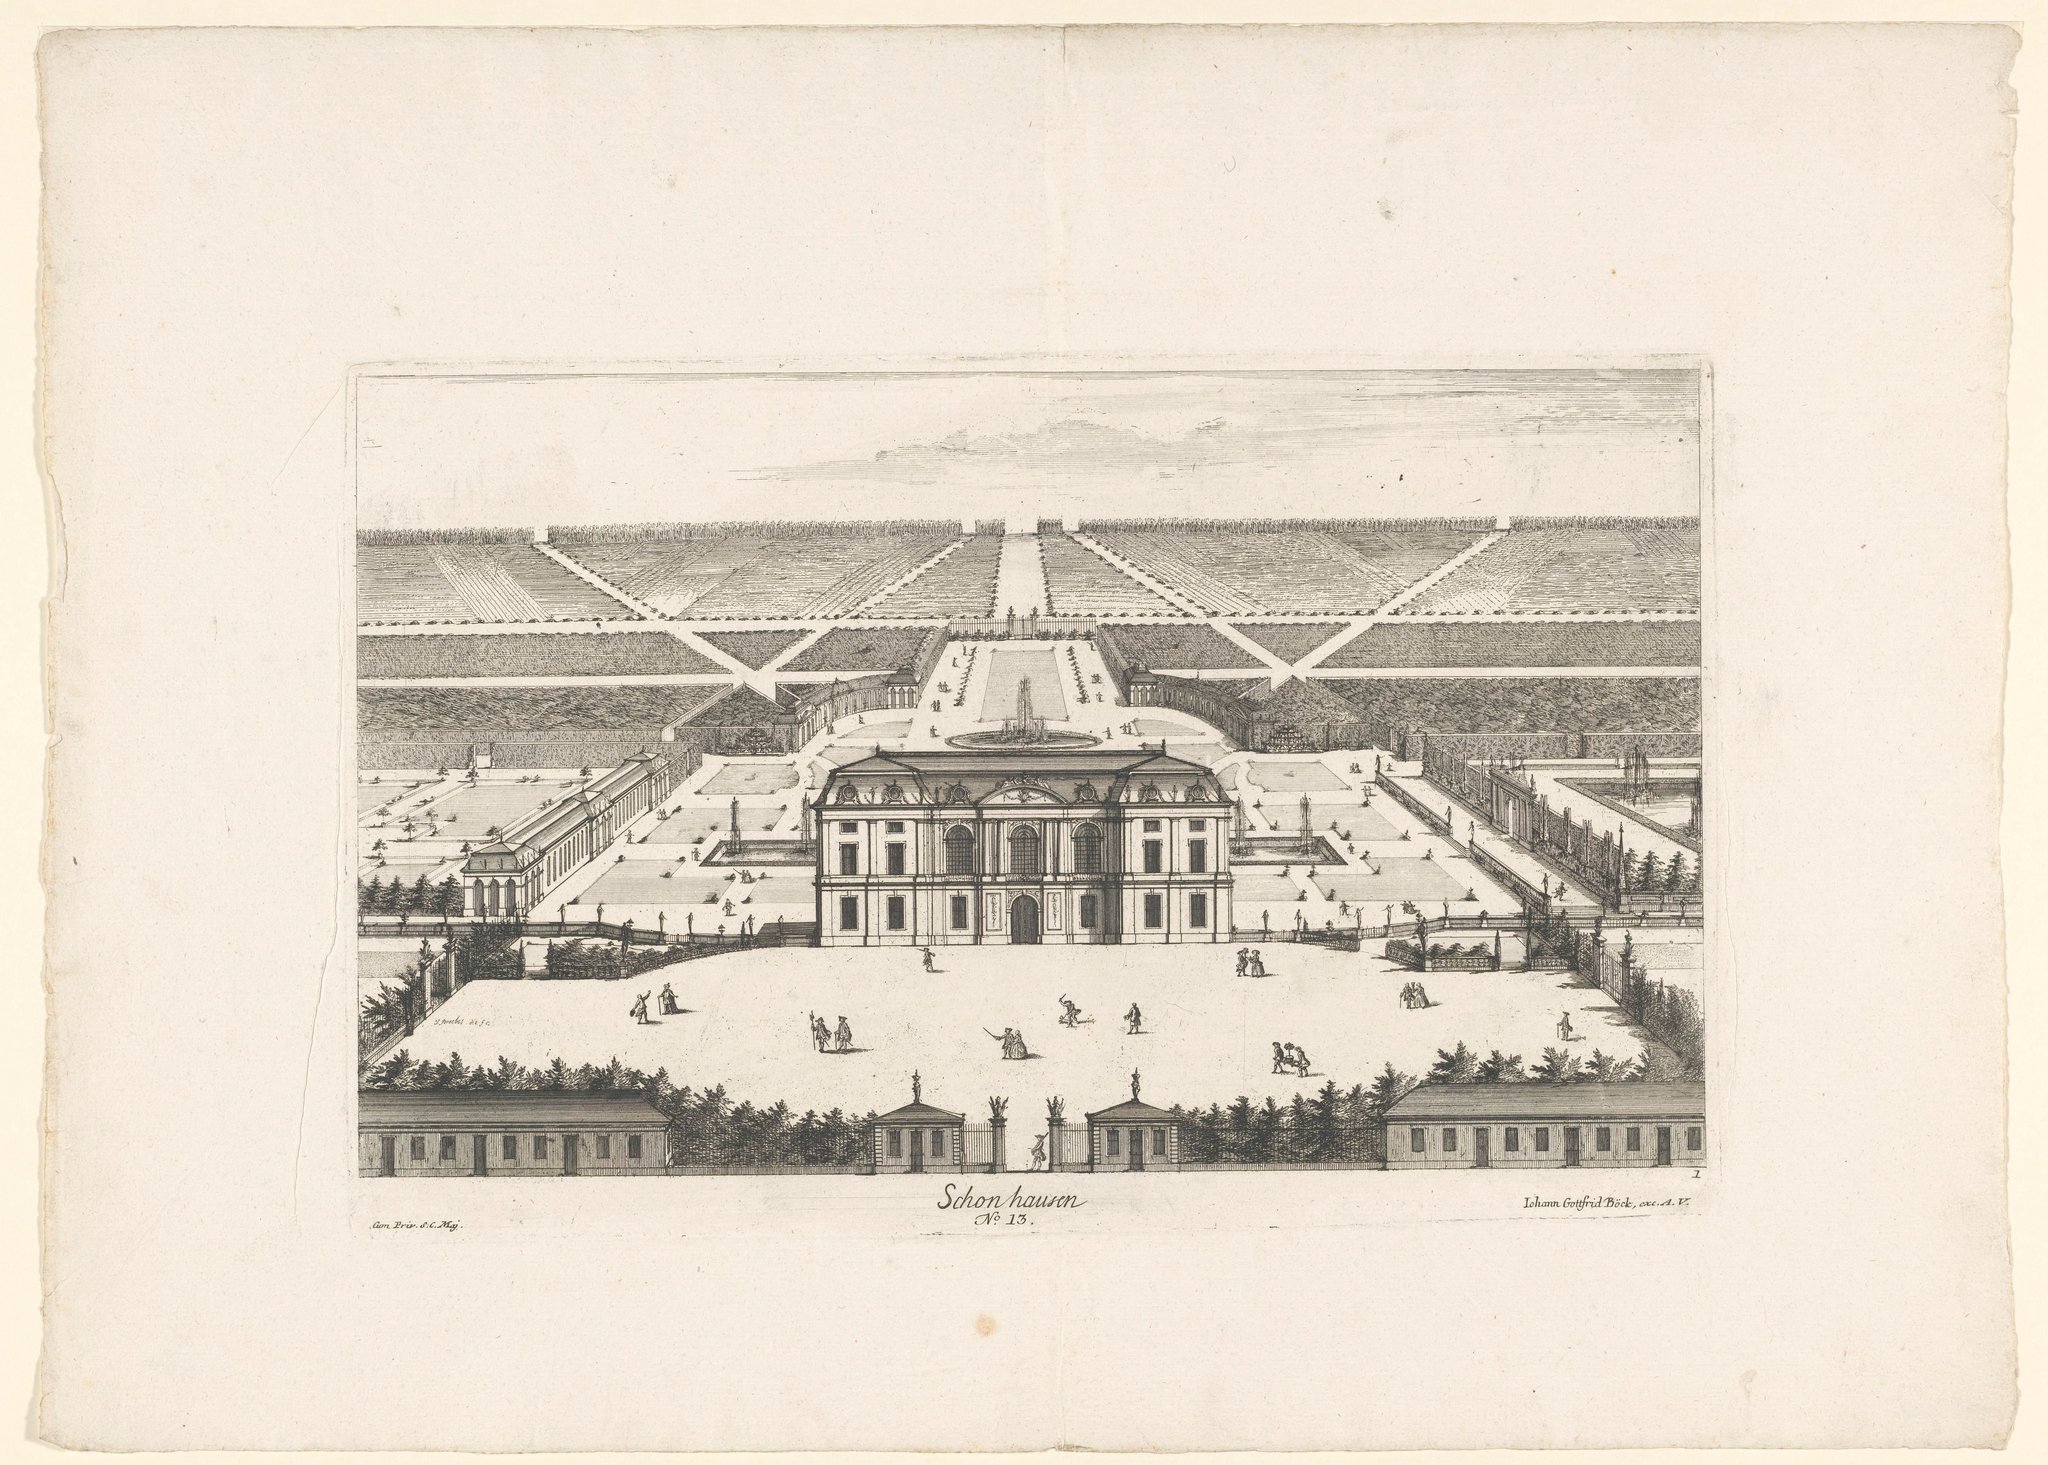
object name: print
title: Gezicht op Schloss Schonhausen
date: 1751-1808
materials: paper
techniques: etching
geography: augsburg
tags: palace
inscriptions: collector's mark: Lugt 2228